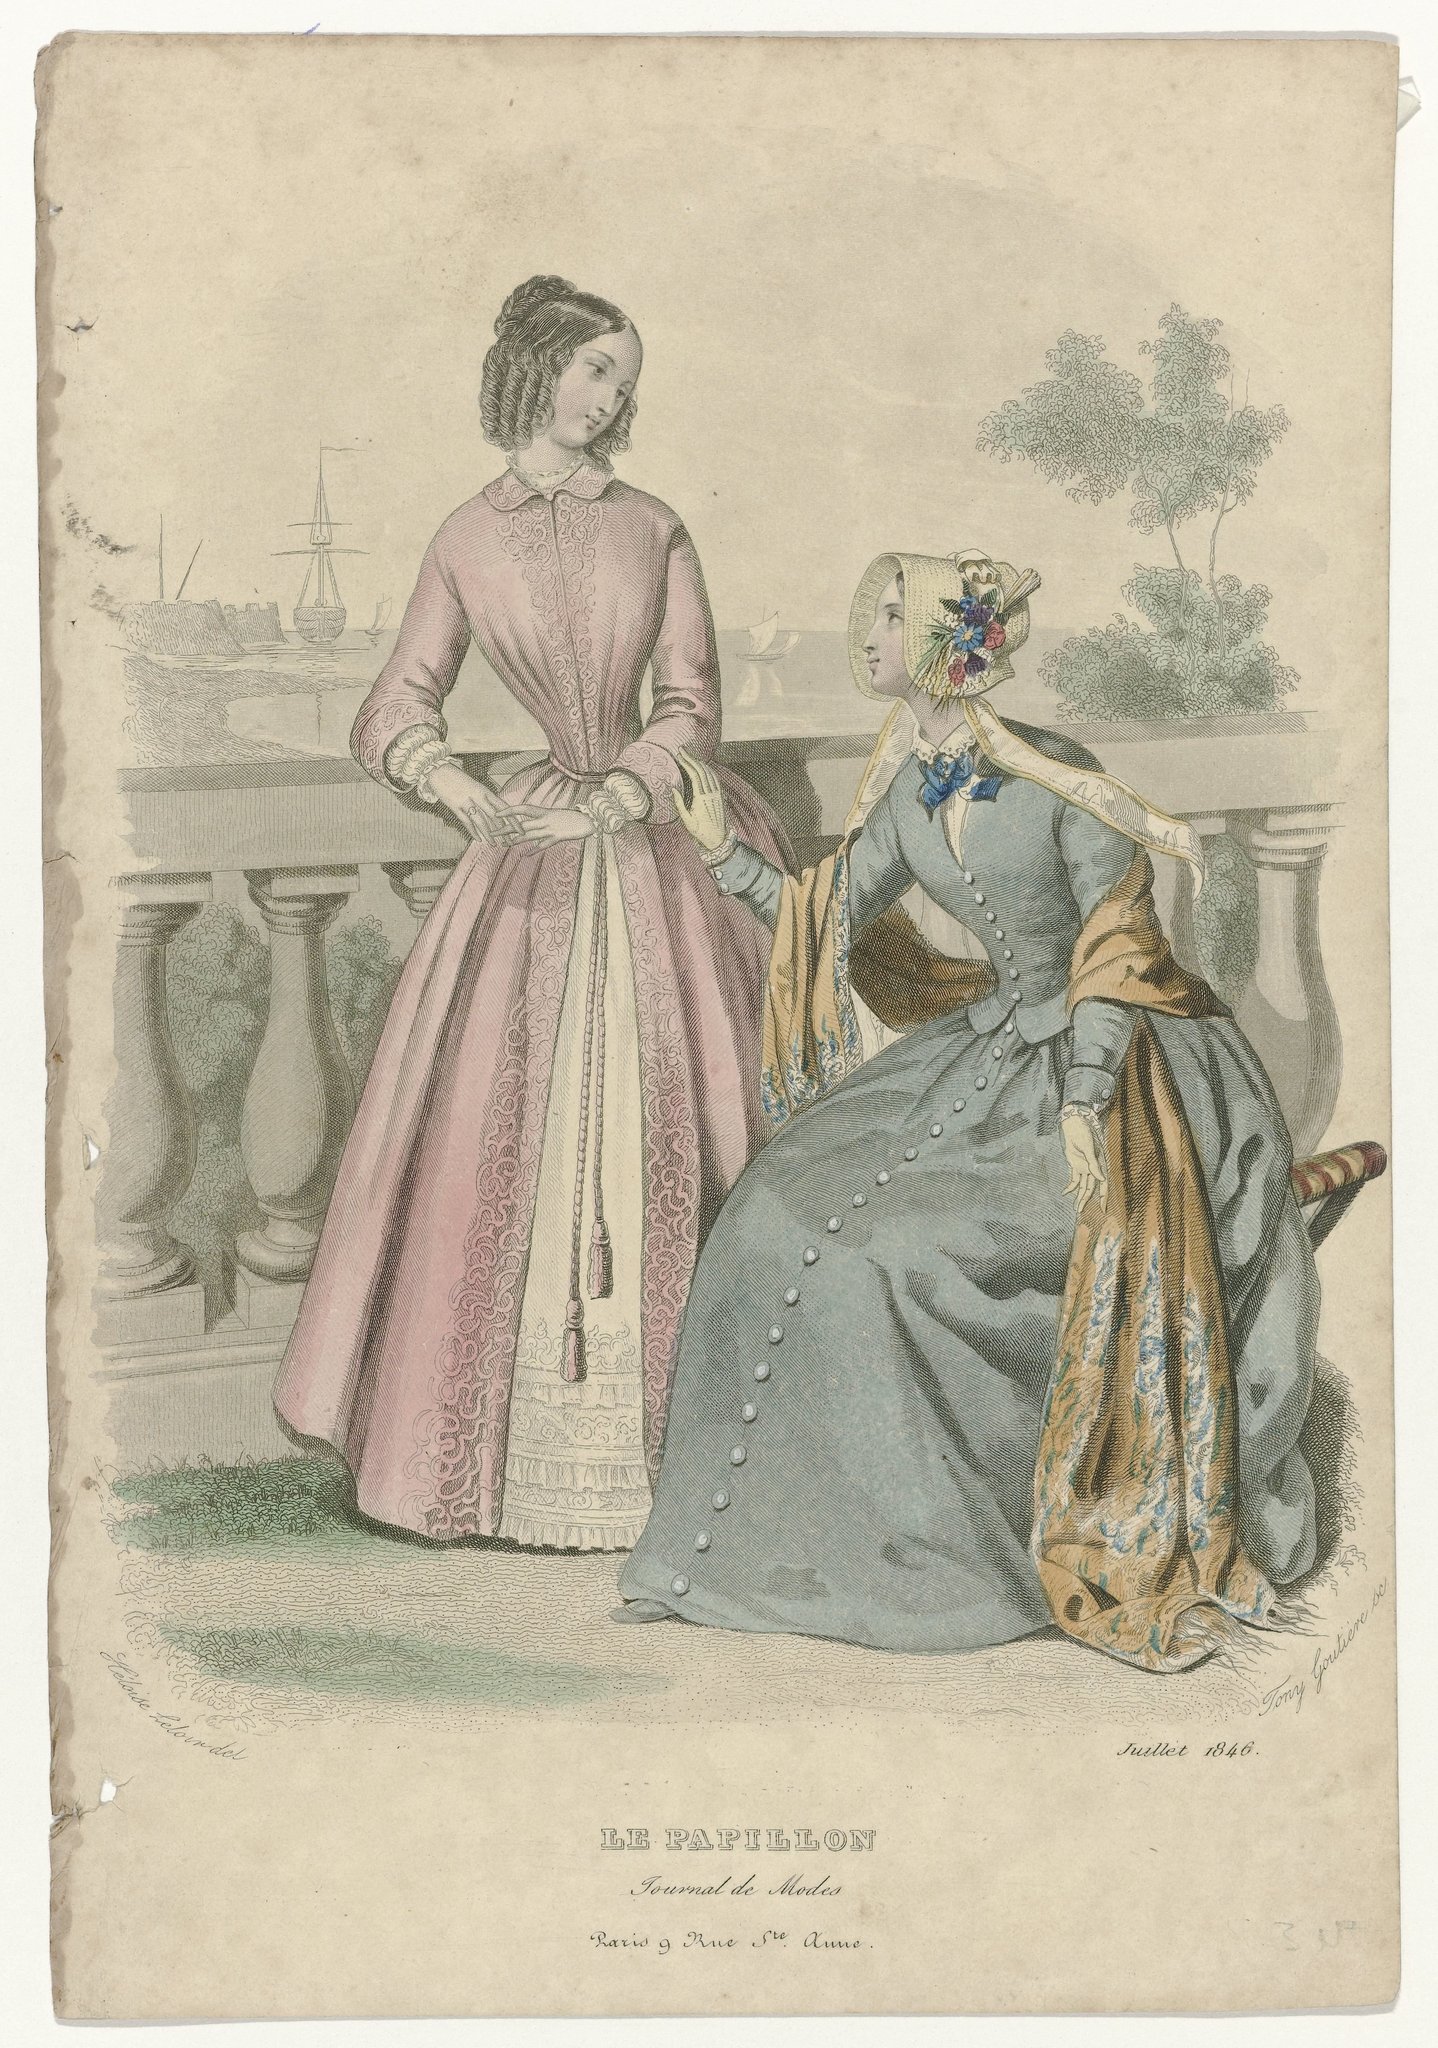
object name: fashion print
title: Le Papillon, Journal de Modes, juillet 1846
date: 1846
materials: paper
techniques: engraving, hand coloring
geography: paris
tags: clothing for the upper part of the body (+ women's clothes), clothing for the upper part of the body (shawl) (+ women's clothes), ring (+ women's clothes), fashion plates, head-gear: hat (+ women's clothes), skirt (+ women's clothes), sea (seascape), balustrade, belt, girdle, waistband (+ women's clothes)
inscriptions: address: ‘Paris 9 Rue S.te Anne.’, title: ‘Le Papillon Journal de Modes’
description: Twee vrouwen bij een balustrade, op de achtergrond boten in een baai. Links: japon met sierrand en geplooide ondermouwen. Onderrok, afgezet met gerimpelde stroken stof. Om het middel een koord met aan de uiteinden kwasten. Rechts: japon met lange mouwen, v-hals en middenvoor een rij knopen. Om de schouders een sjaal. Prent uit het modetijdschrift Le Papillon (1842-1848).